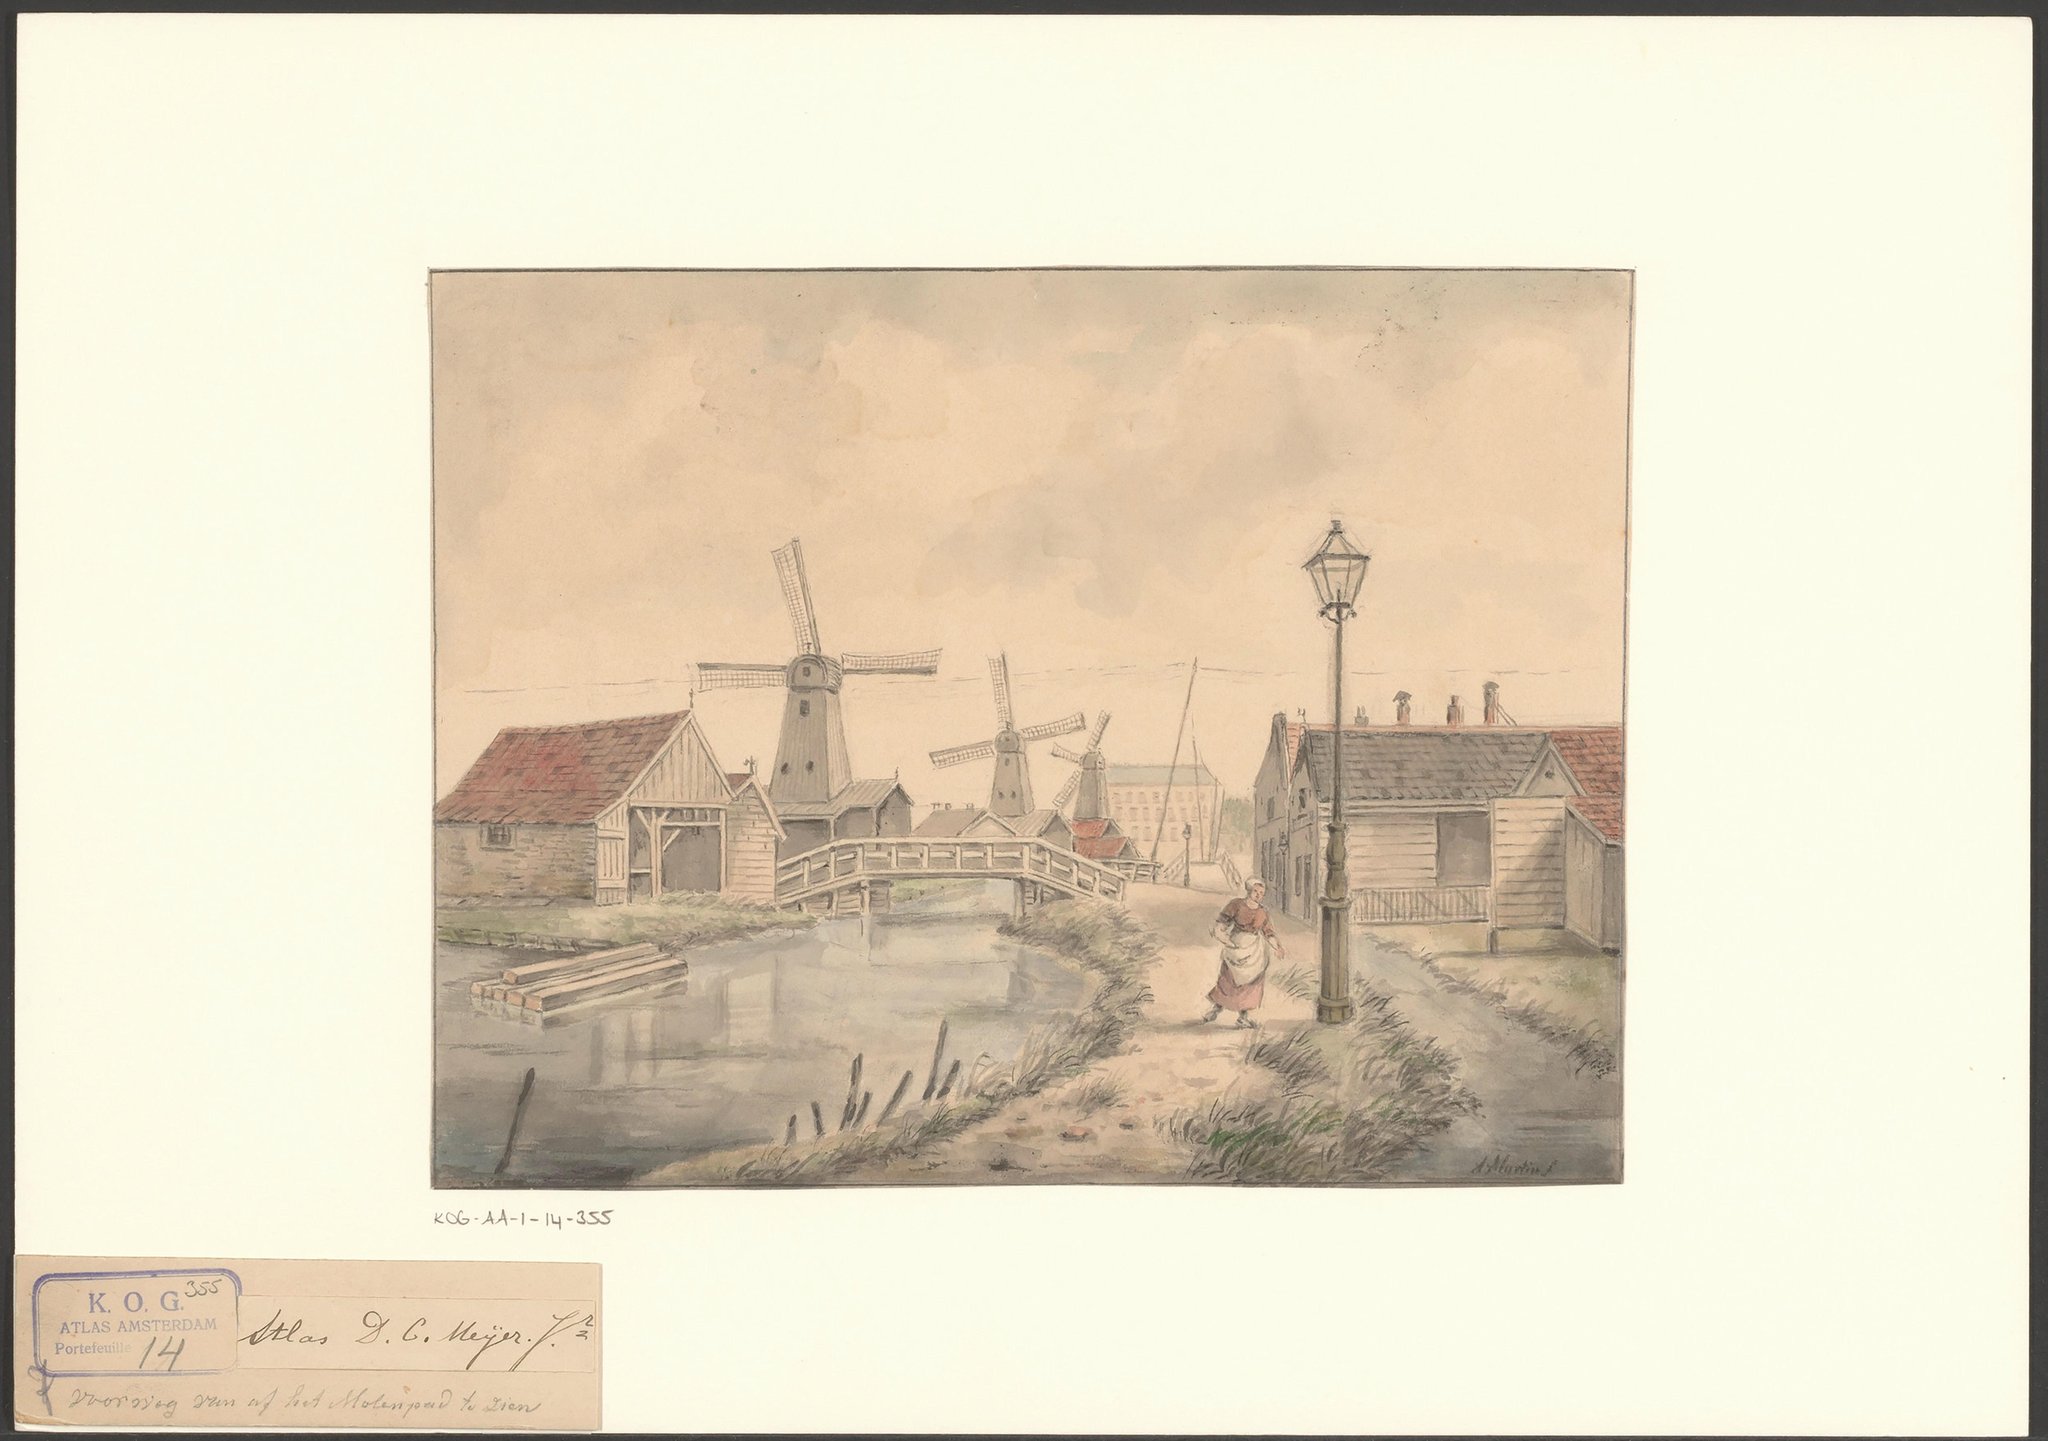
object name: drawing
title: Gezicht op de Voorweg, gezien vanaf het Molenpad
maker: albert martin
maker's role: draughtsman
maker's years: 1827-1900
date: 1837-1900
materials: ink, paper, pencil, watercolor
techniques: brush, pen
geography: amsterdam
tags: city-view in general; 'veduta', road, path, windmill in landscape, bridge in city across river, canal, etc., small canal, ditch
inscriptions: signature: ‘AMartin f’, inscription: ‘Port. 14-355’, inscription: ‘Atlas D.C. Meijer. Jr. / voorweg van af het Molenpad te zien’, collector's mark: ‘14’ Lugt 1641b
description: Onderwerpsrubriek binnen de Atlas Amsterdam: Voorburgwal (O.Z.), Voorweg, Vijgendam, Vijzelstraat.